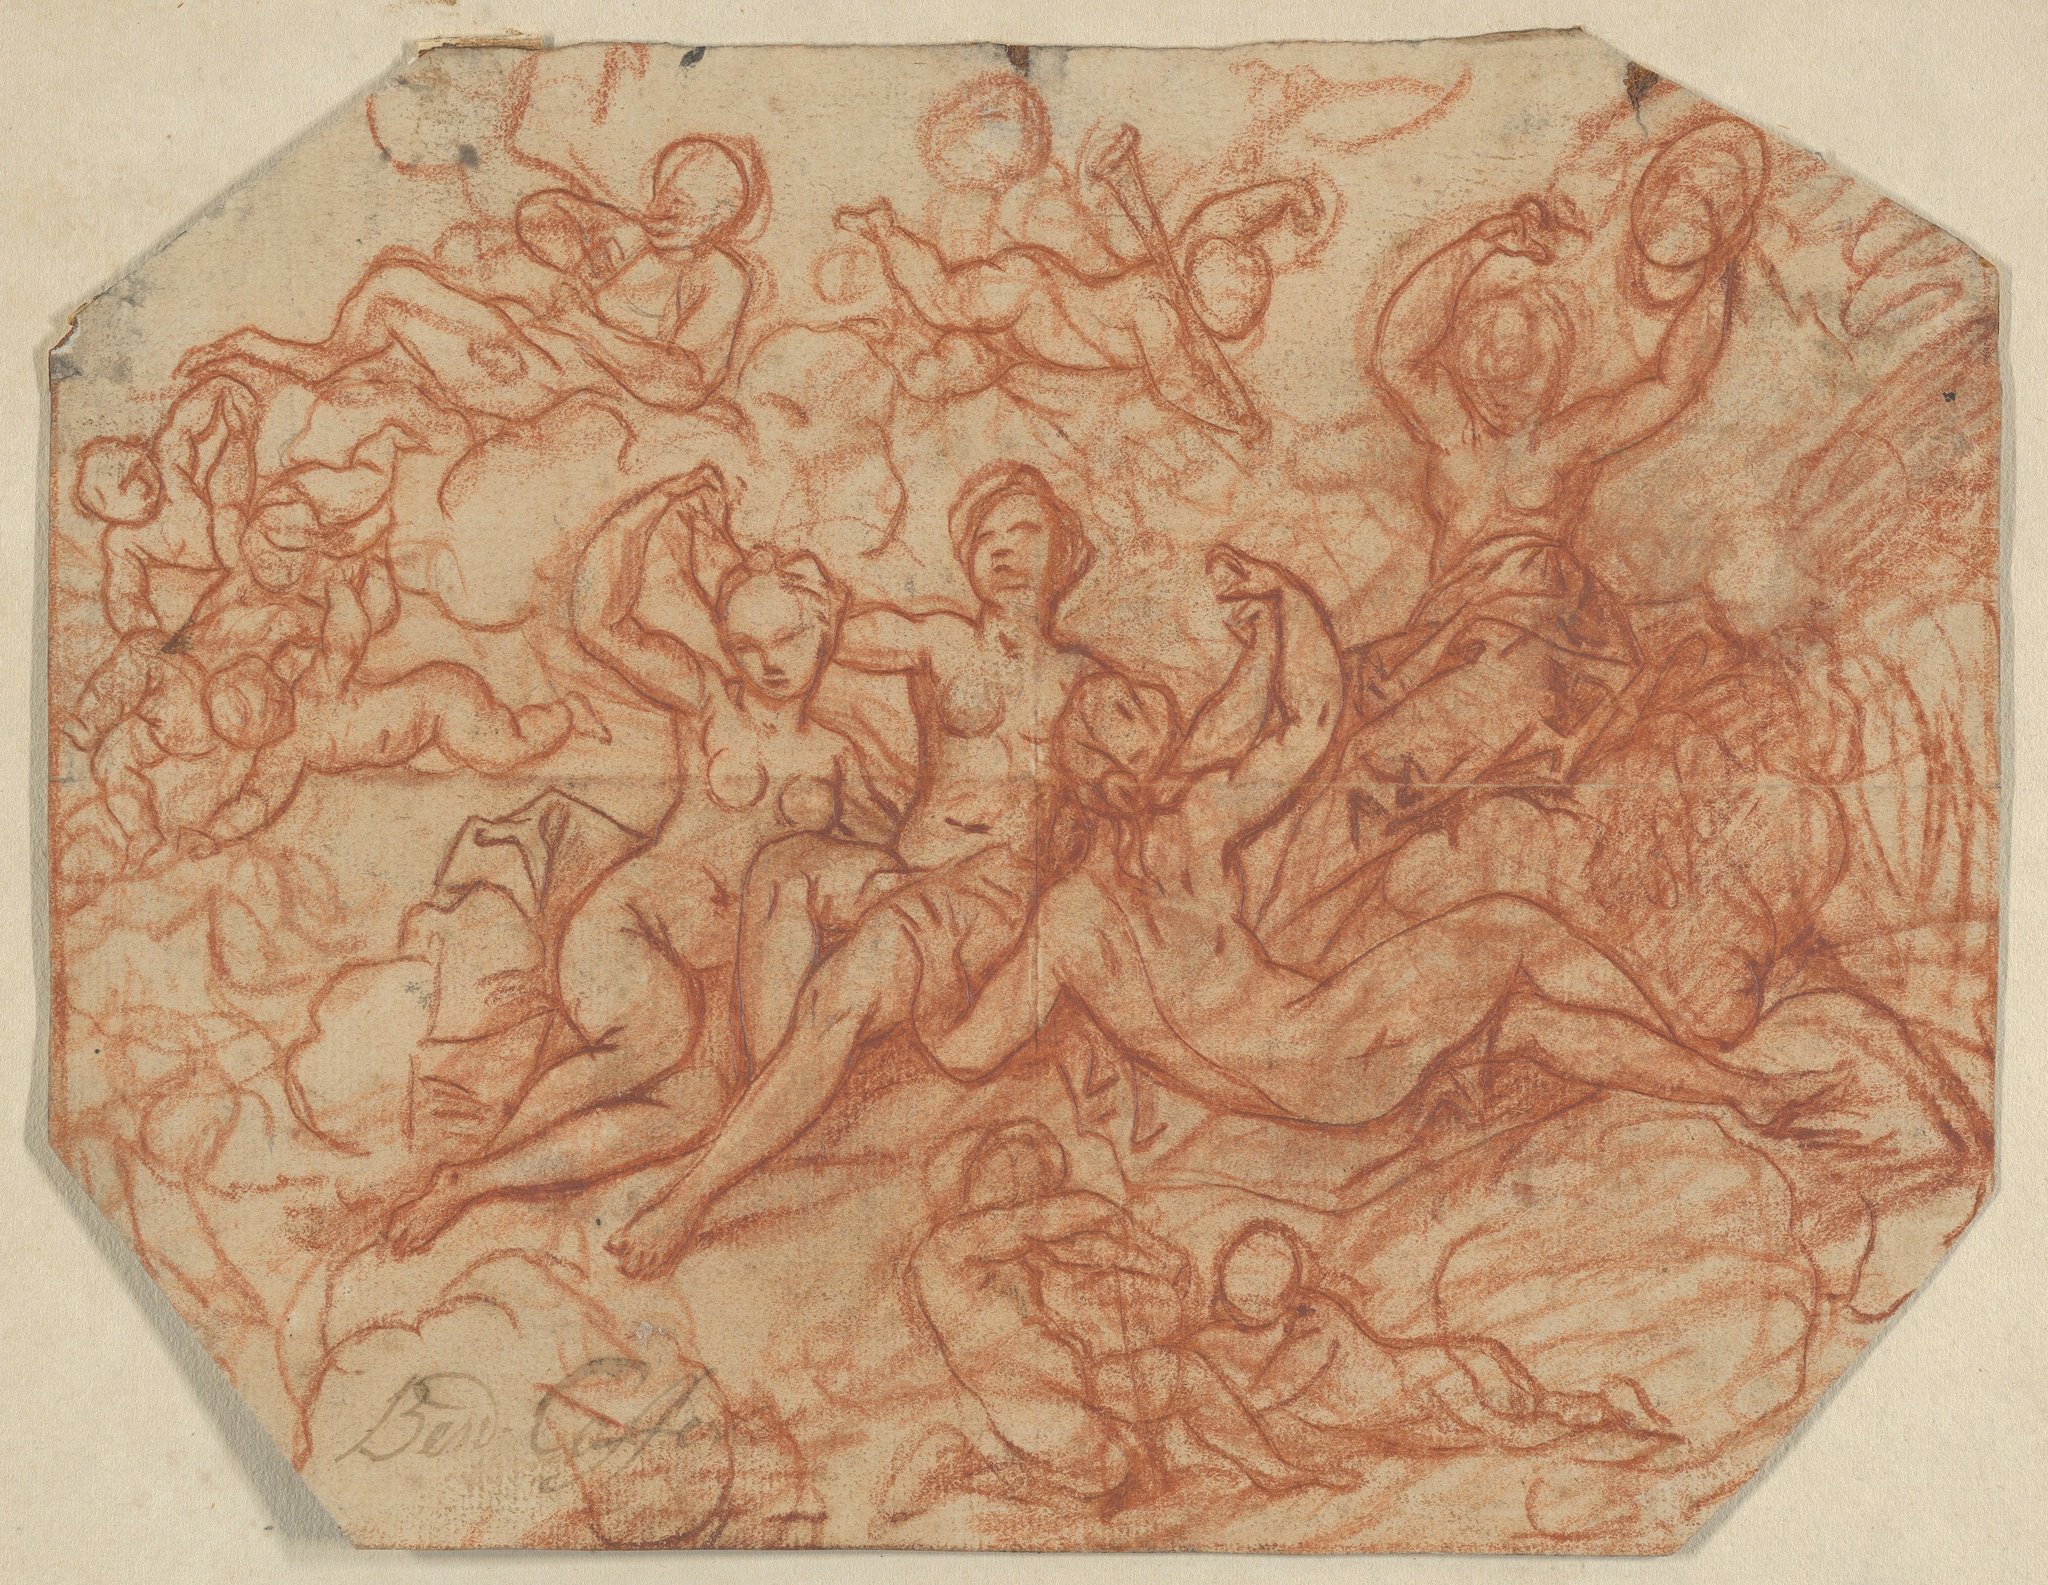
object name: drawing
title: Four (?) Nude Women in the Clouds Surrounded by Putti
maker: benoît le coffre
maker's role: artist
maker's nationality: danish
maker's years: 1671-1722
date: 1667-1733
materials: chalk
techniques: incising, transfer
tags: female nudes